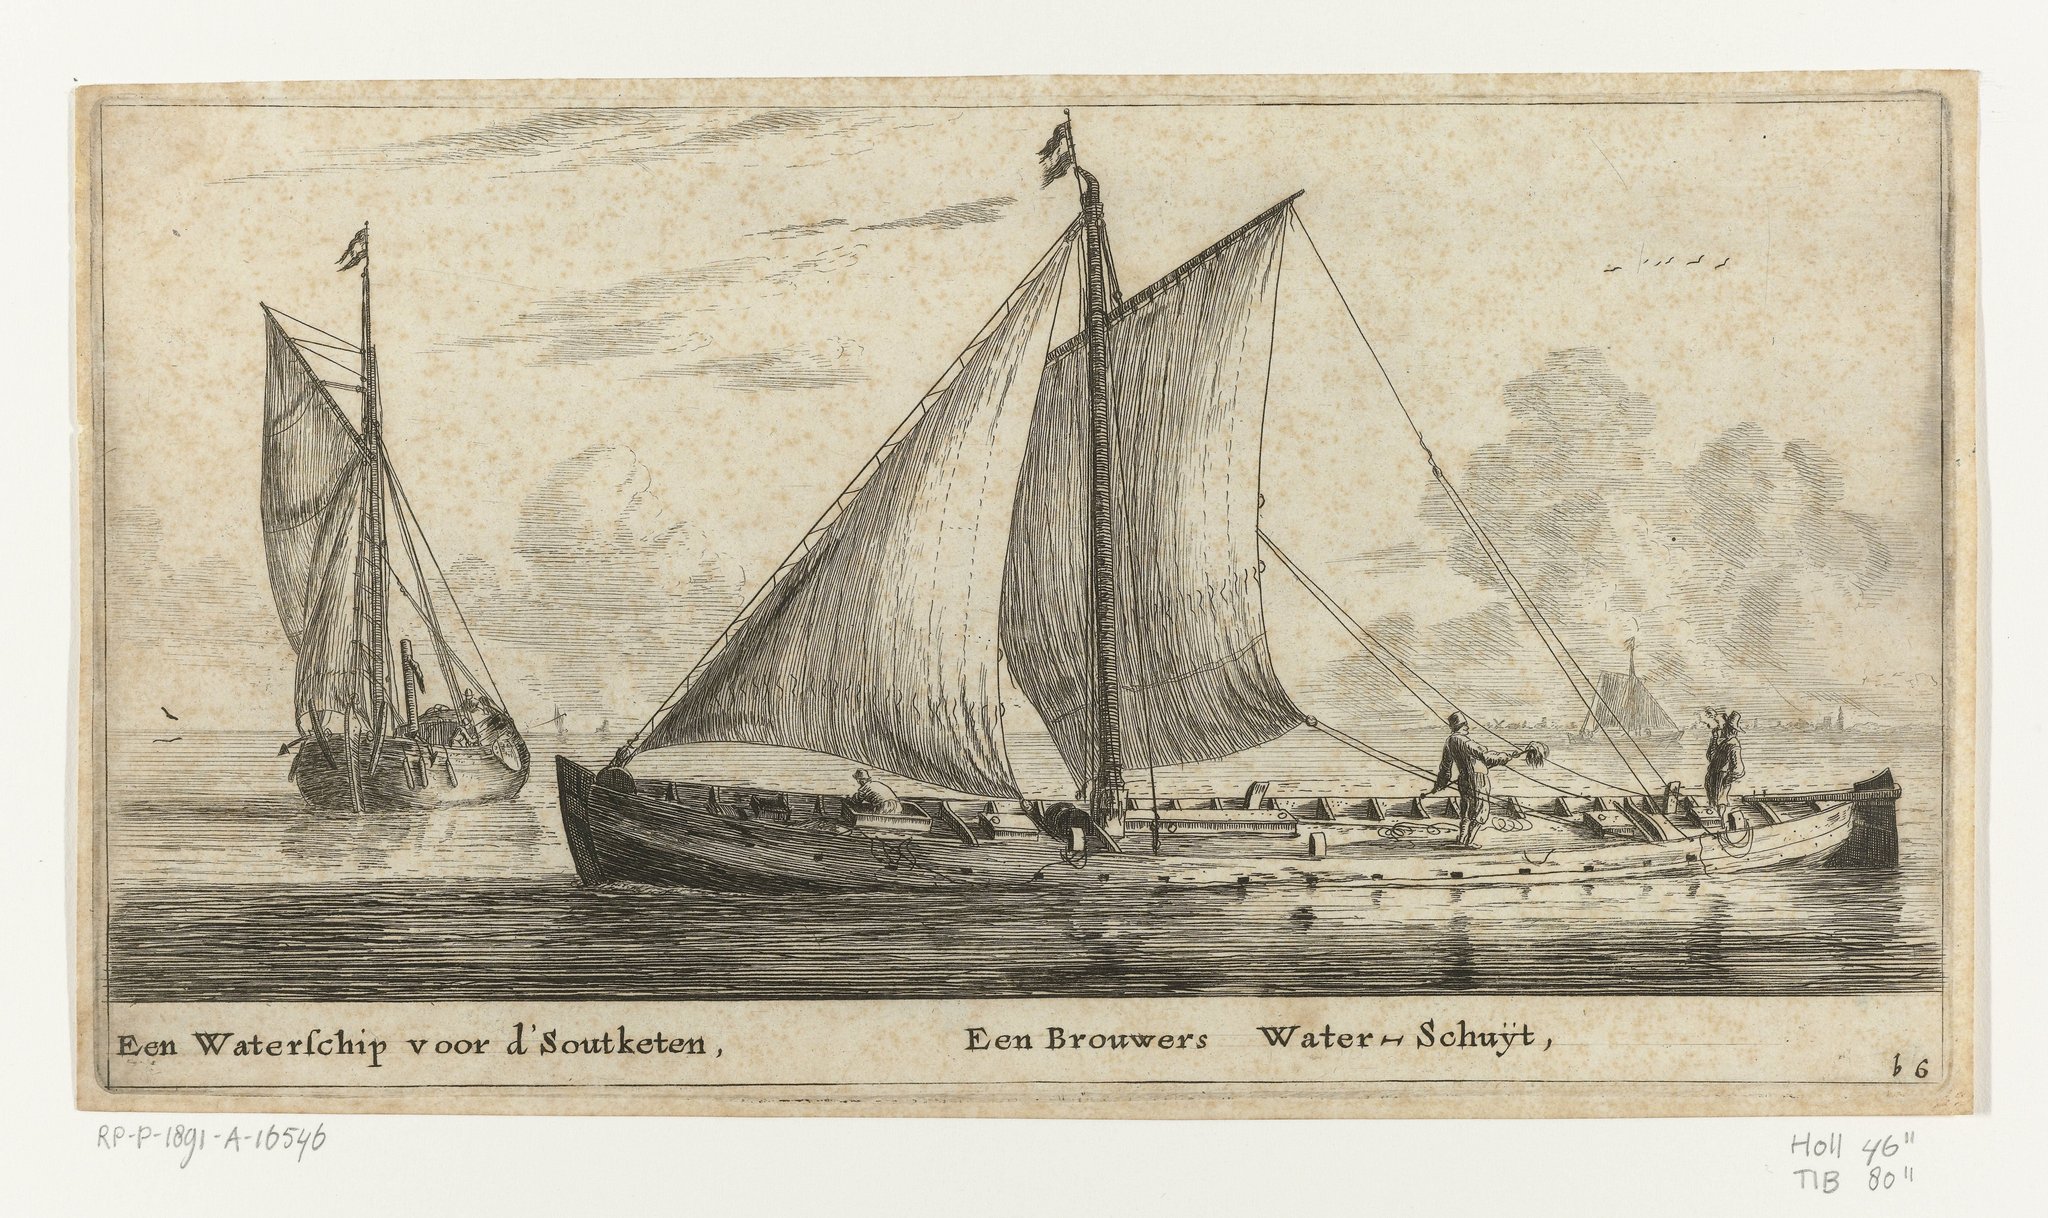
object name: print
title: Een Waterschip voor Soutketen, Een Brouwers Water-Schuÿt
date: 1652-1654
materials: paper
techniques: drypoint, etching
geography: netherlands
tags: ships (in general)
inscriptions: collector's mark: Lugt 1494, collector's mark: Lugt 462, collector's mark: Lugt 1227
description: Een waterschuit met water voor een brouwerij op de voorgrond, meer naar achter een waterschip met water voor een zoutziederij.